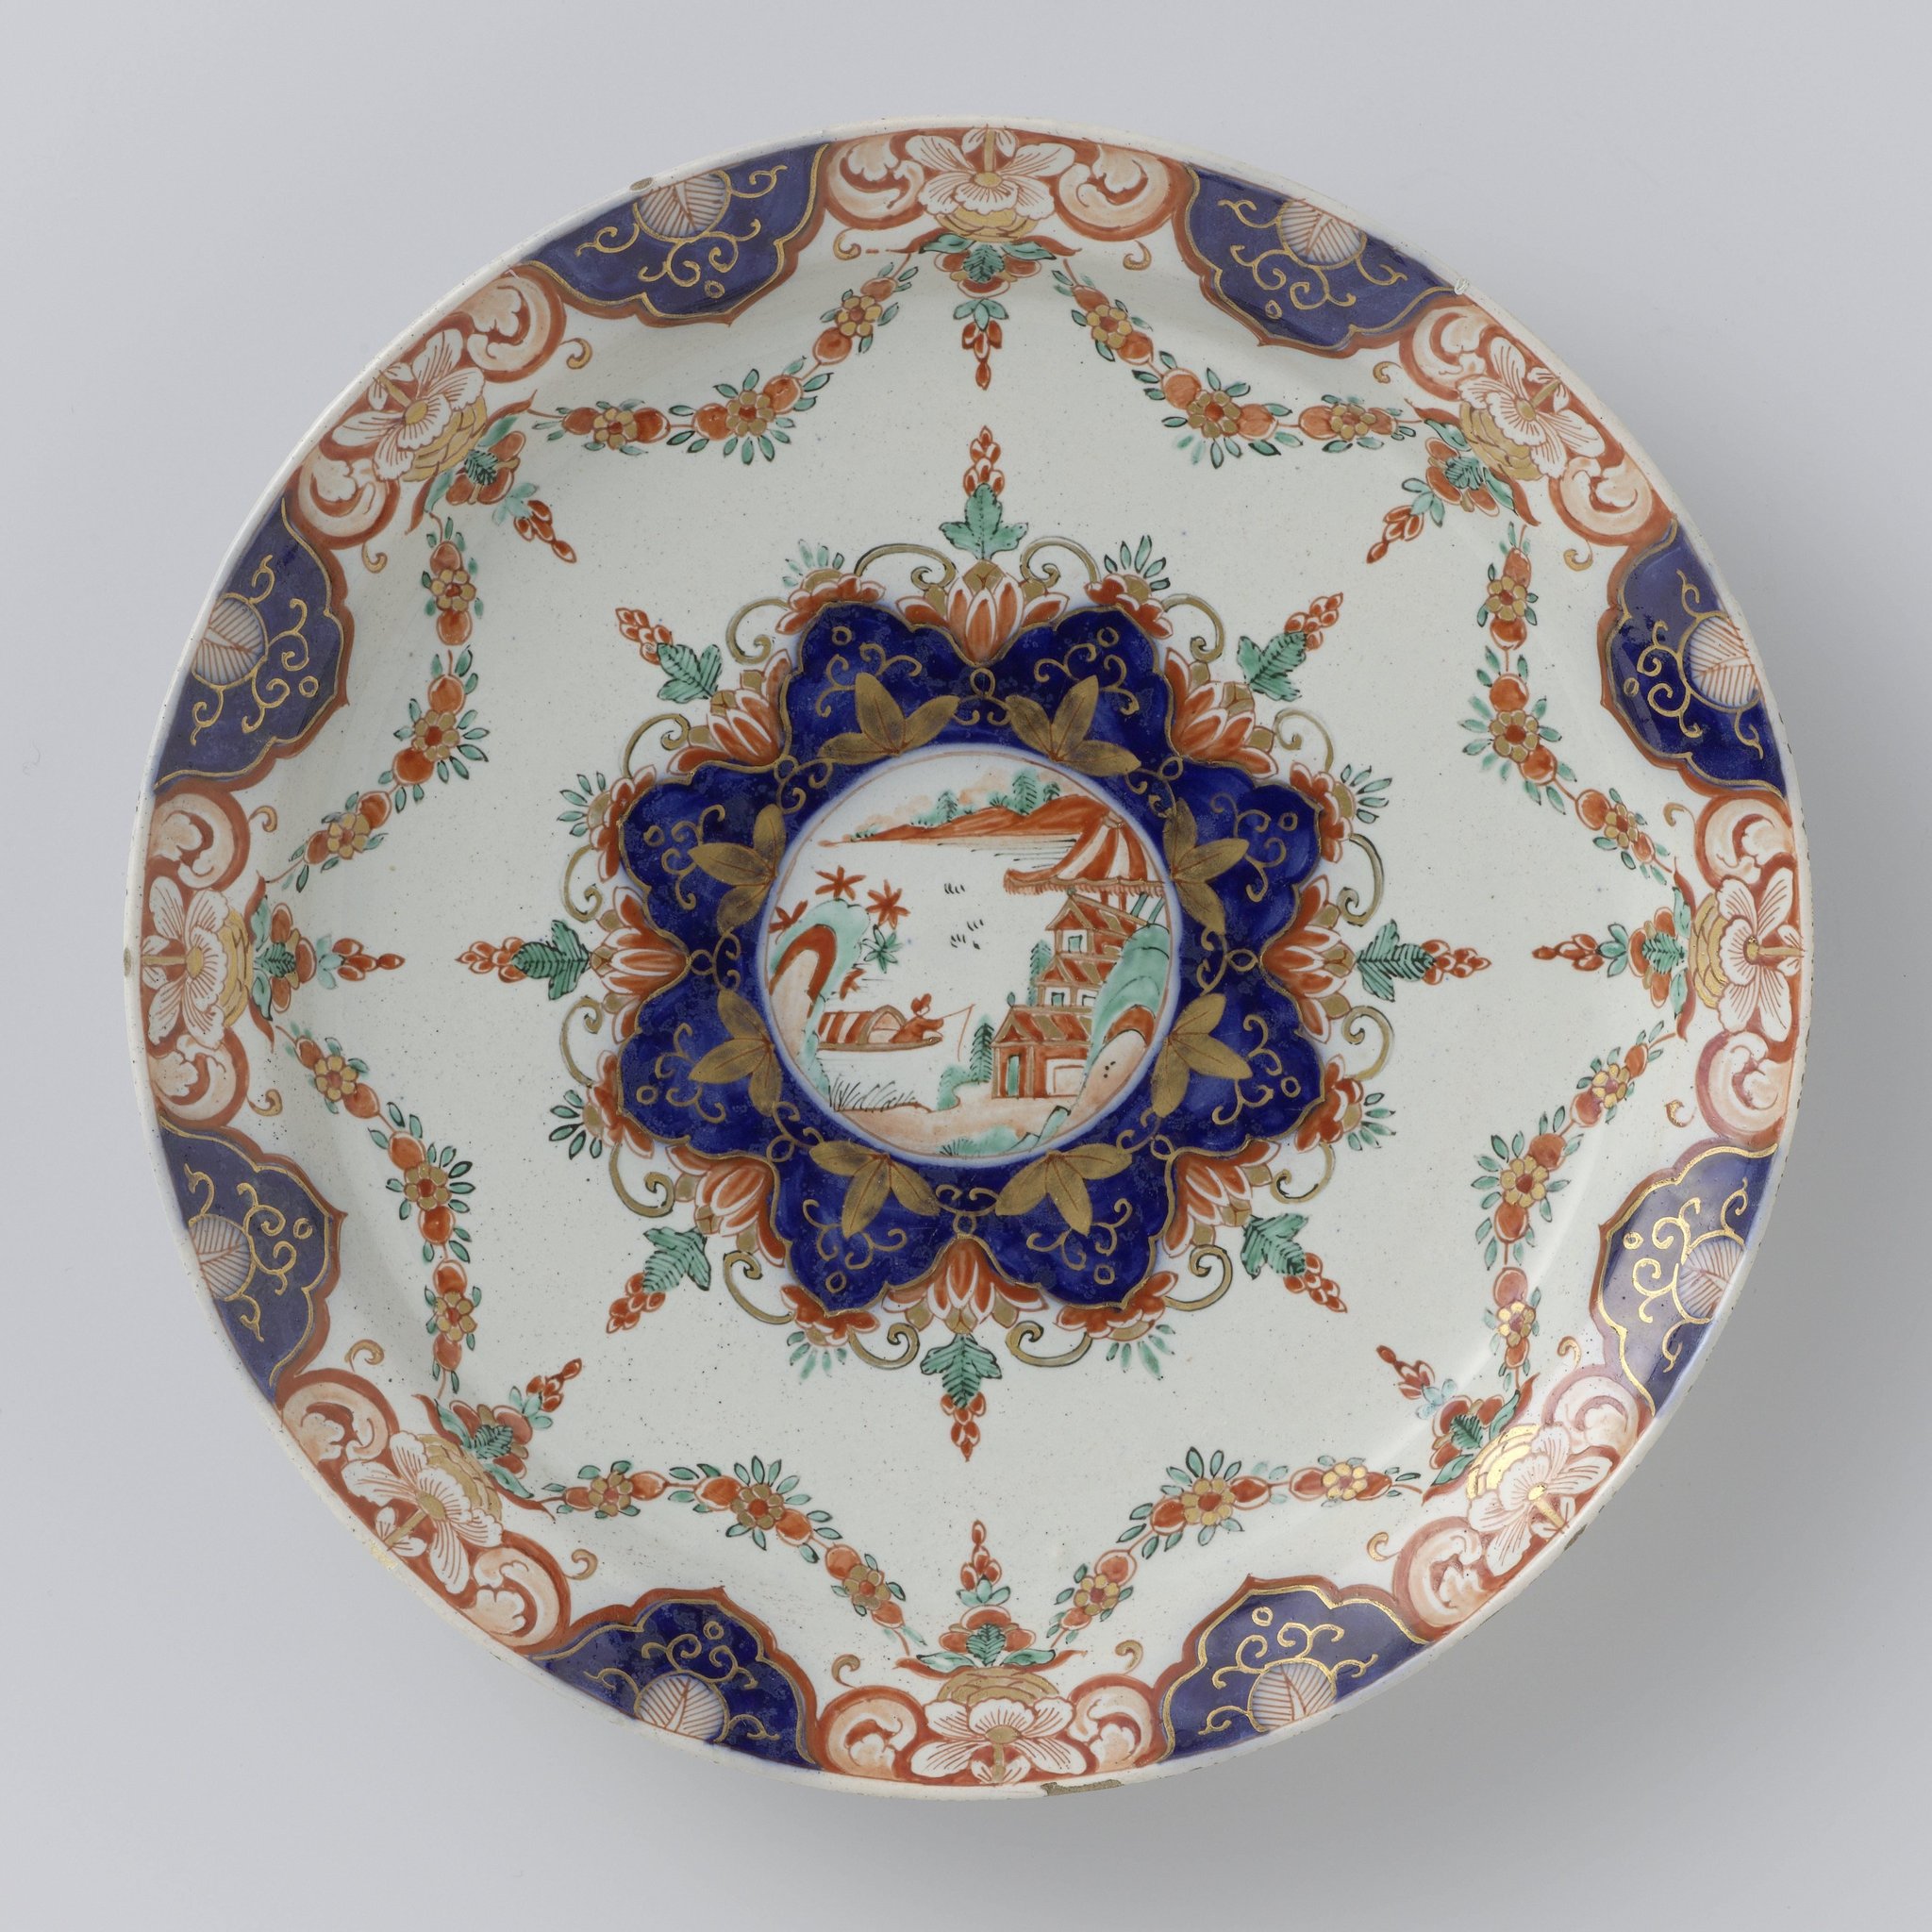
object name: plate dish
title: Bord van veelkleurig beschilderde faïence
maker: Anonymous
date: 1700-1725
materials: faience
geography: delft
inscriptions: collector's mark: ‘collection loudon’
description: Bord van faïence. Veelkleurig beschilderd met een Chinees waterlandschap en lambrequins, in imari kleuren.